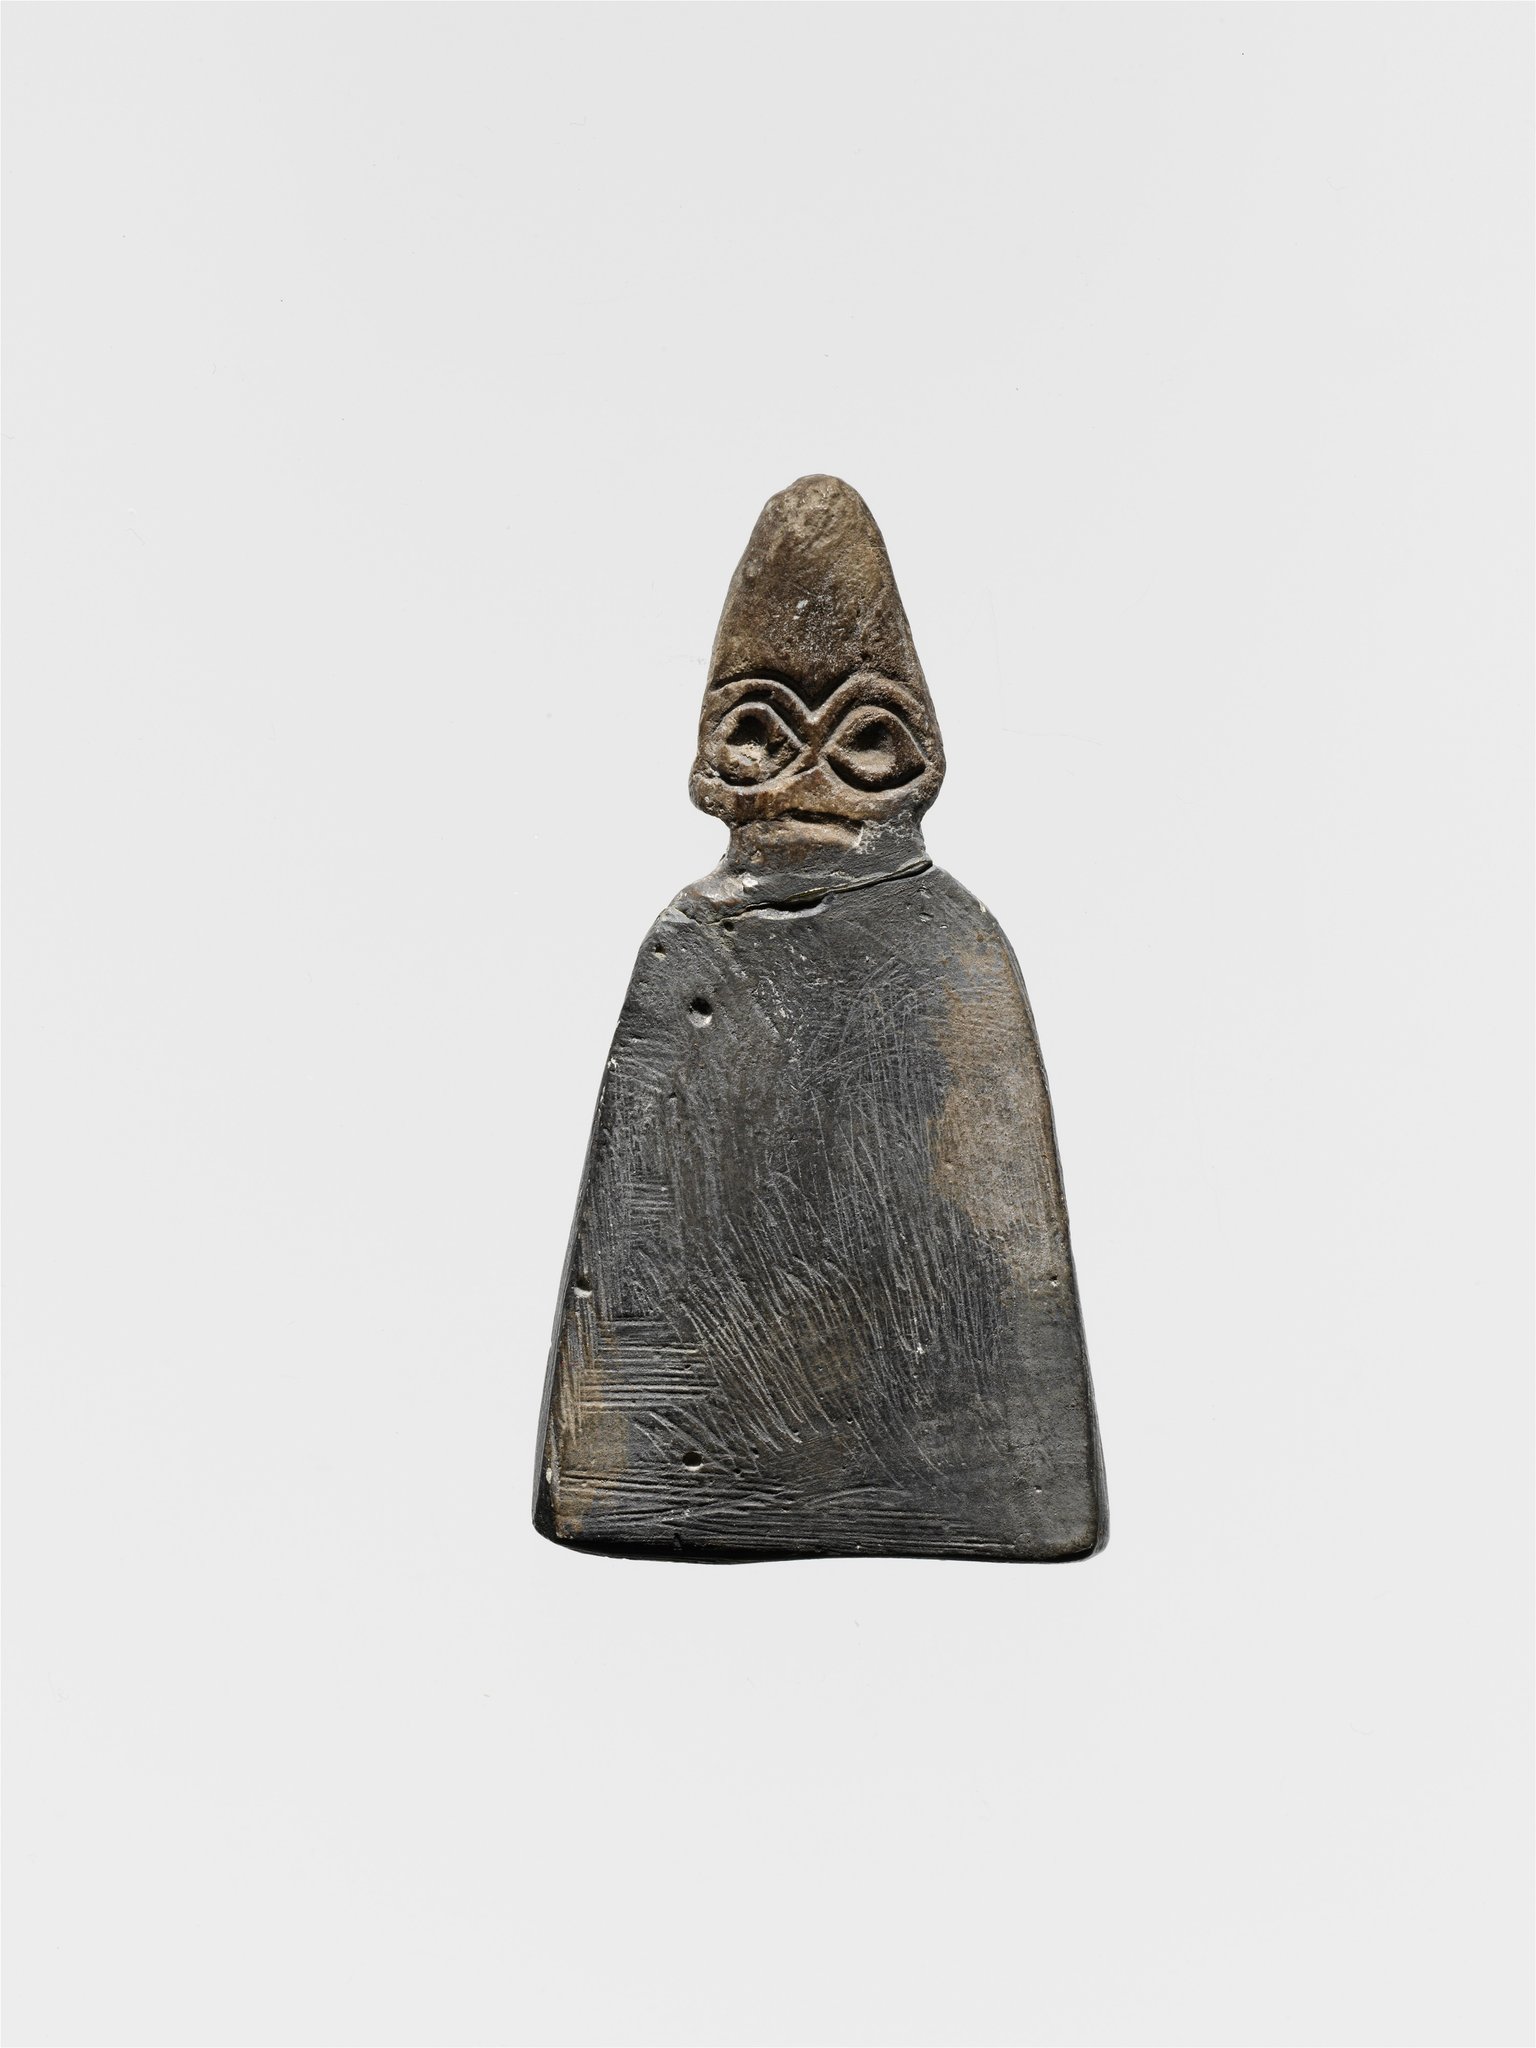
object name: sculpture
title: Eye idol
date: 3700-3500 BCE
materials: alabaster, gypsum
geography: syria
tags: eyes